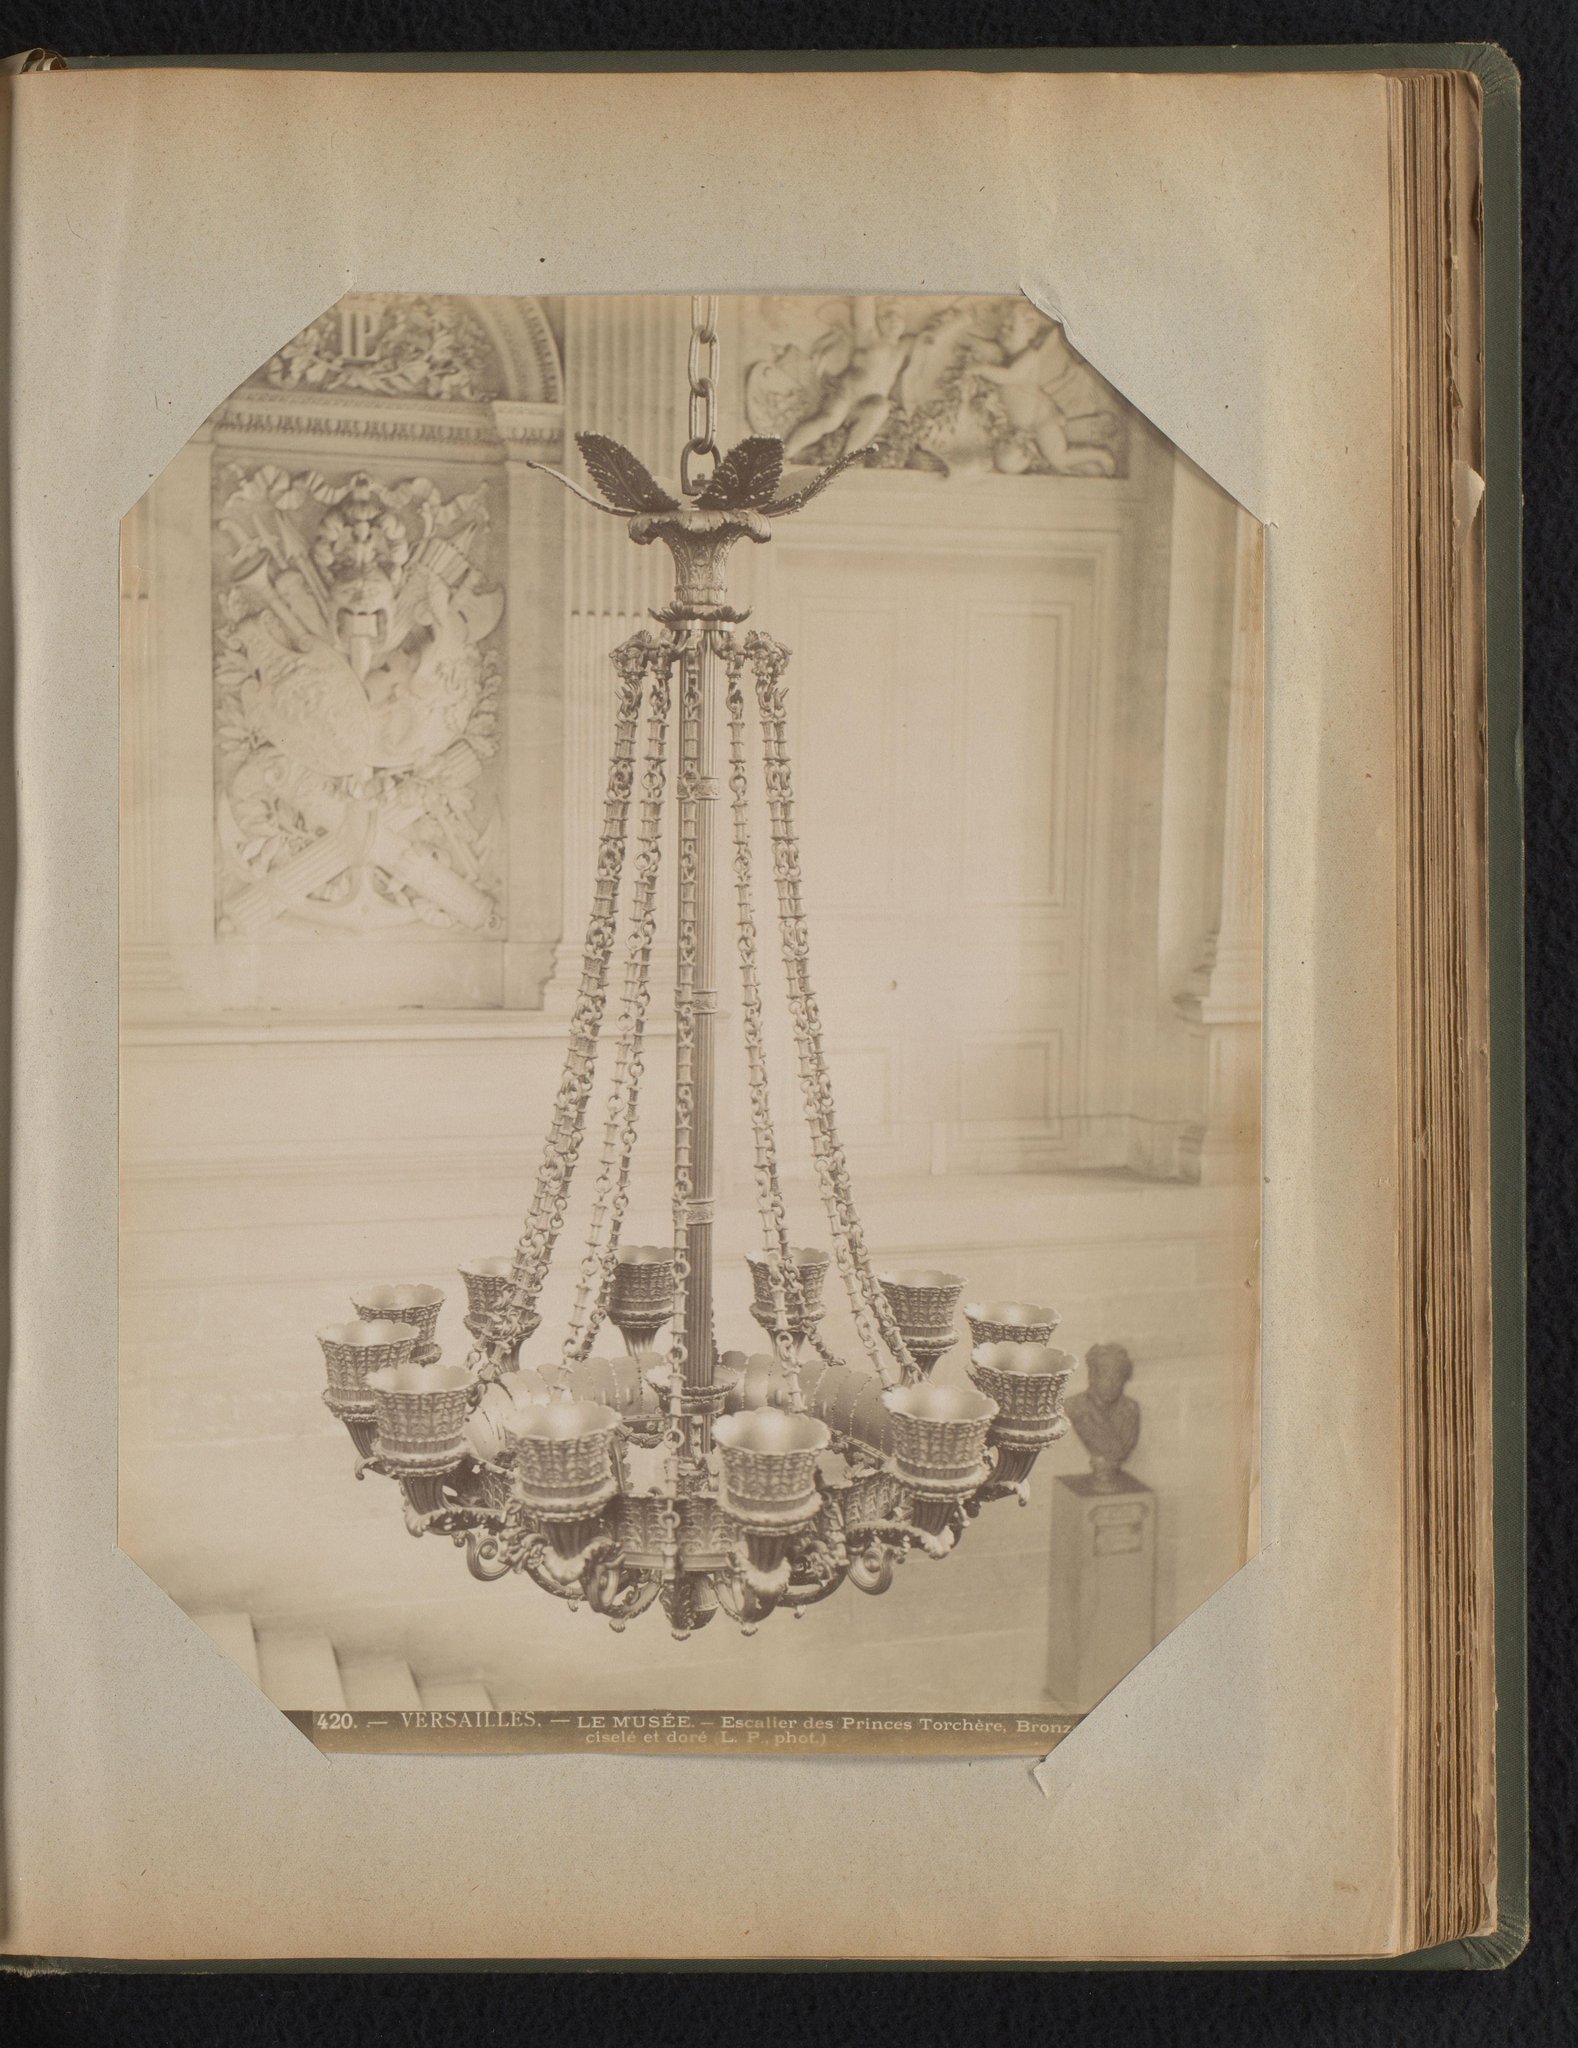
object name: photograph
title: 420. - Versailles - Le Musee - Escalier des Princes Torchere , Bronze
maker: Anonymous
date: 1860-1900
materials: paper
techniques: albumen print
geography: netherlands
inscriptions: annotation: ‘420. - Versailles - Le Musee - Escalier des Princes Torchere , Bronze’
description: Op de bronzen basis zijn ornamenten in de vorm van bladeren aangebracht.